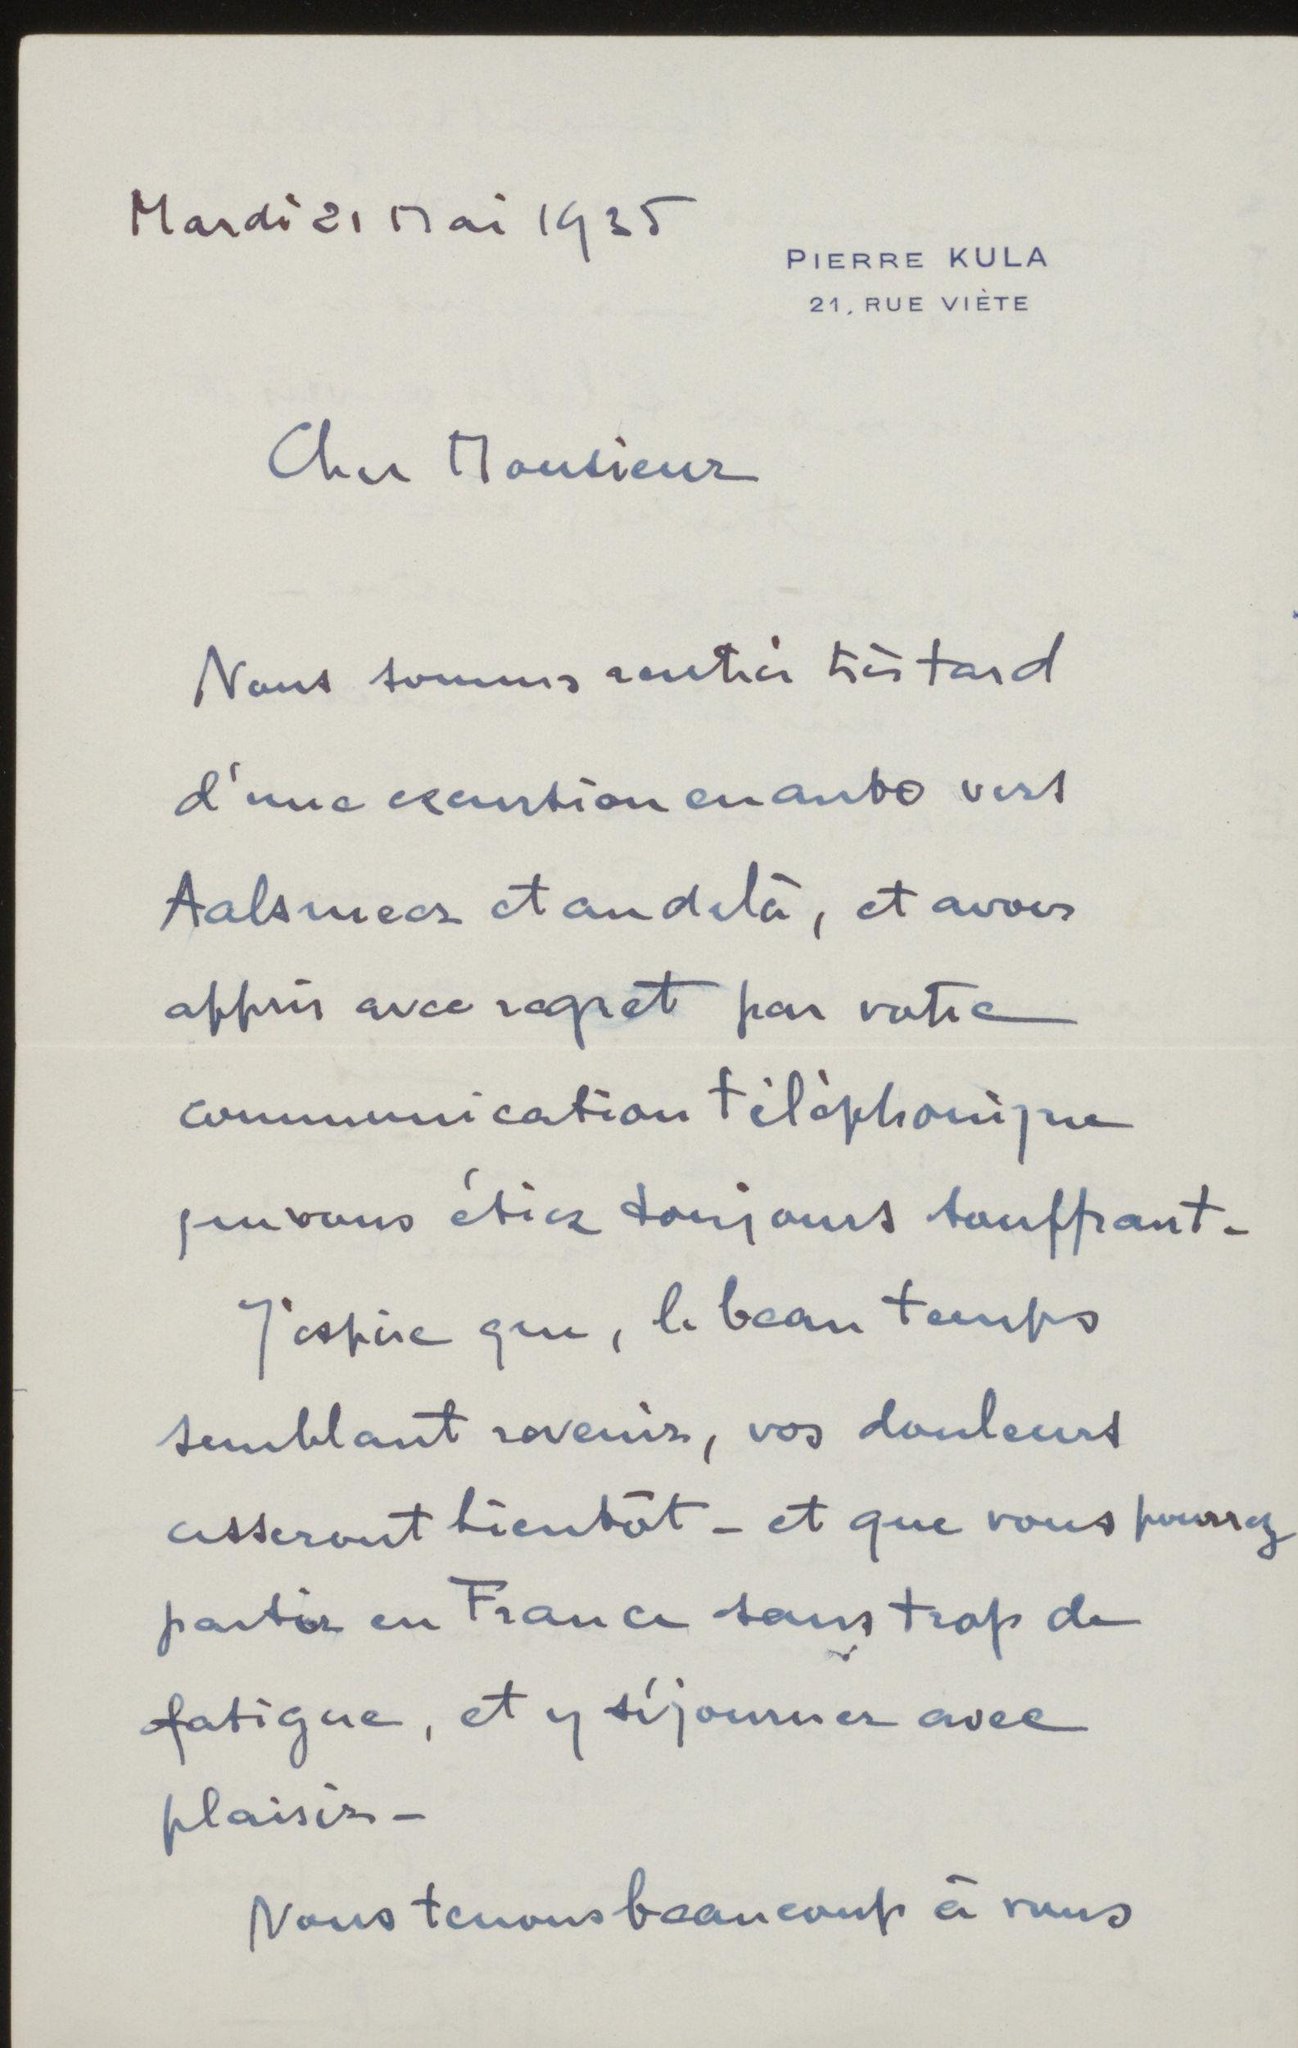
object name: letter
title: Brief aan Andries Bonger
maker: pierre kula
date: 1935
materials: ink, paper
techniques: pen, printing, writing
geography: paris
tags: andries bonger, enkhuizen, haarlem, france, paris